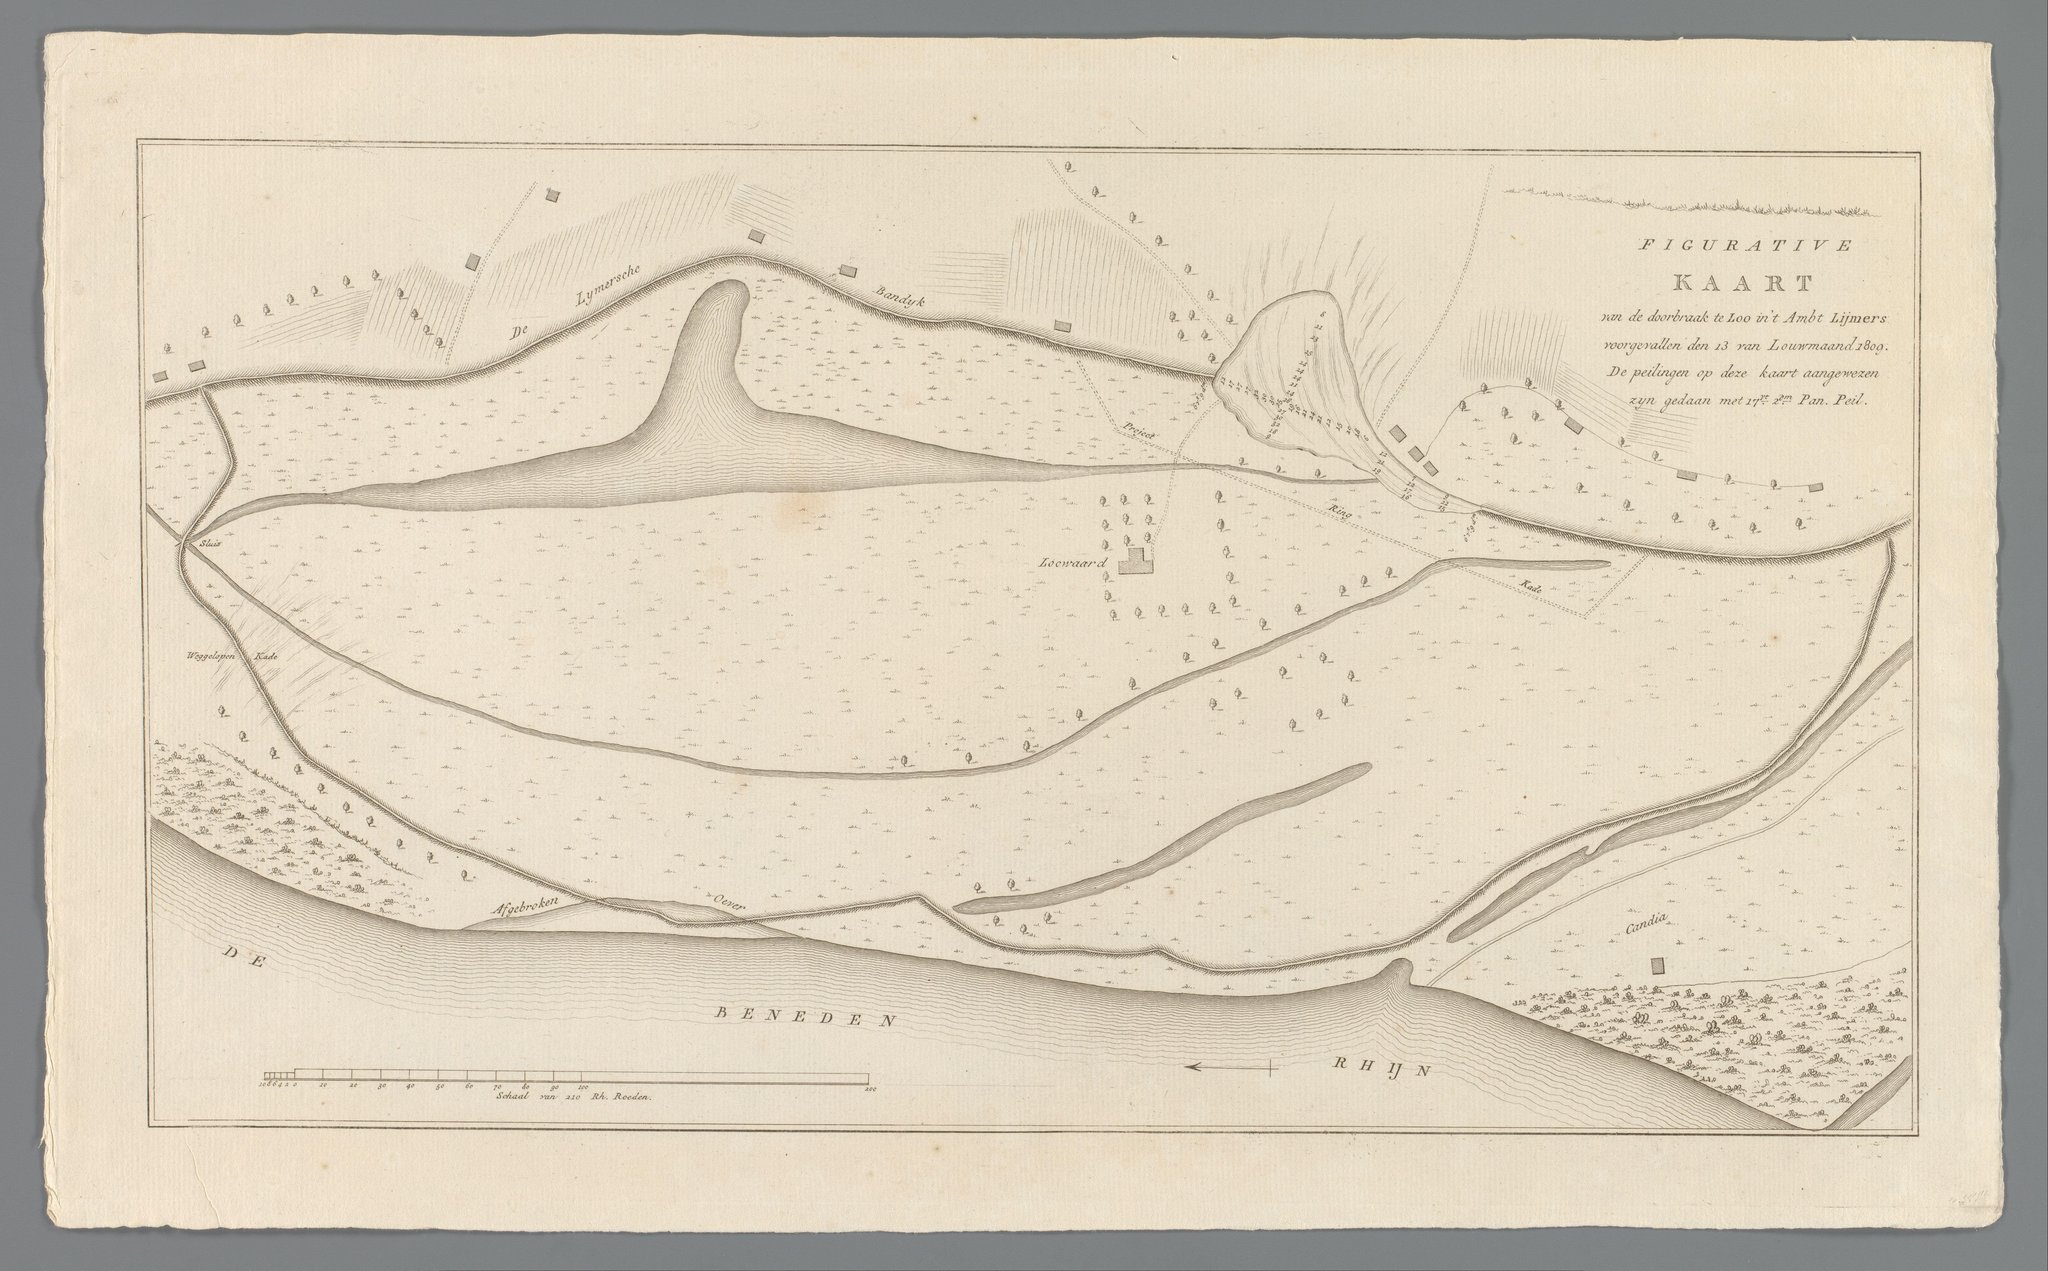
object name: map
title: Kaart van dijkdoorbraak te Loo, 1809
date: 1809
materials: paper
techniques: engraving, etching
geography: amsterdam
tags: dike-break, maps of separate countries or regions, lower rhine region, gelderland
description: Prent ook gebruikt ter illustratie van: Hendrik Ewijk. Geschiedkundig verslag der dijkbreuken en overstroomingen, langs de rivieren in het Koningrijk Holland, voorgevallen in louwmaand MDCCCIX. 3 dln. Amsterdam: Johannes Allart en Jacobus Ruys, 1809.